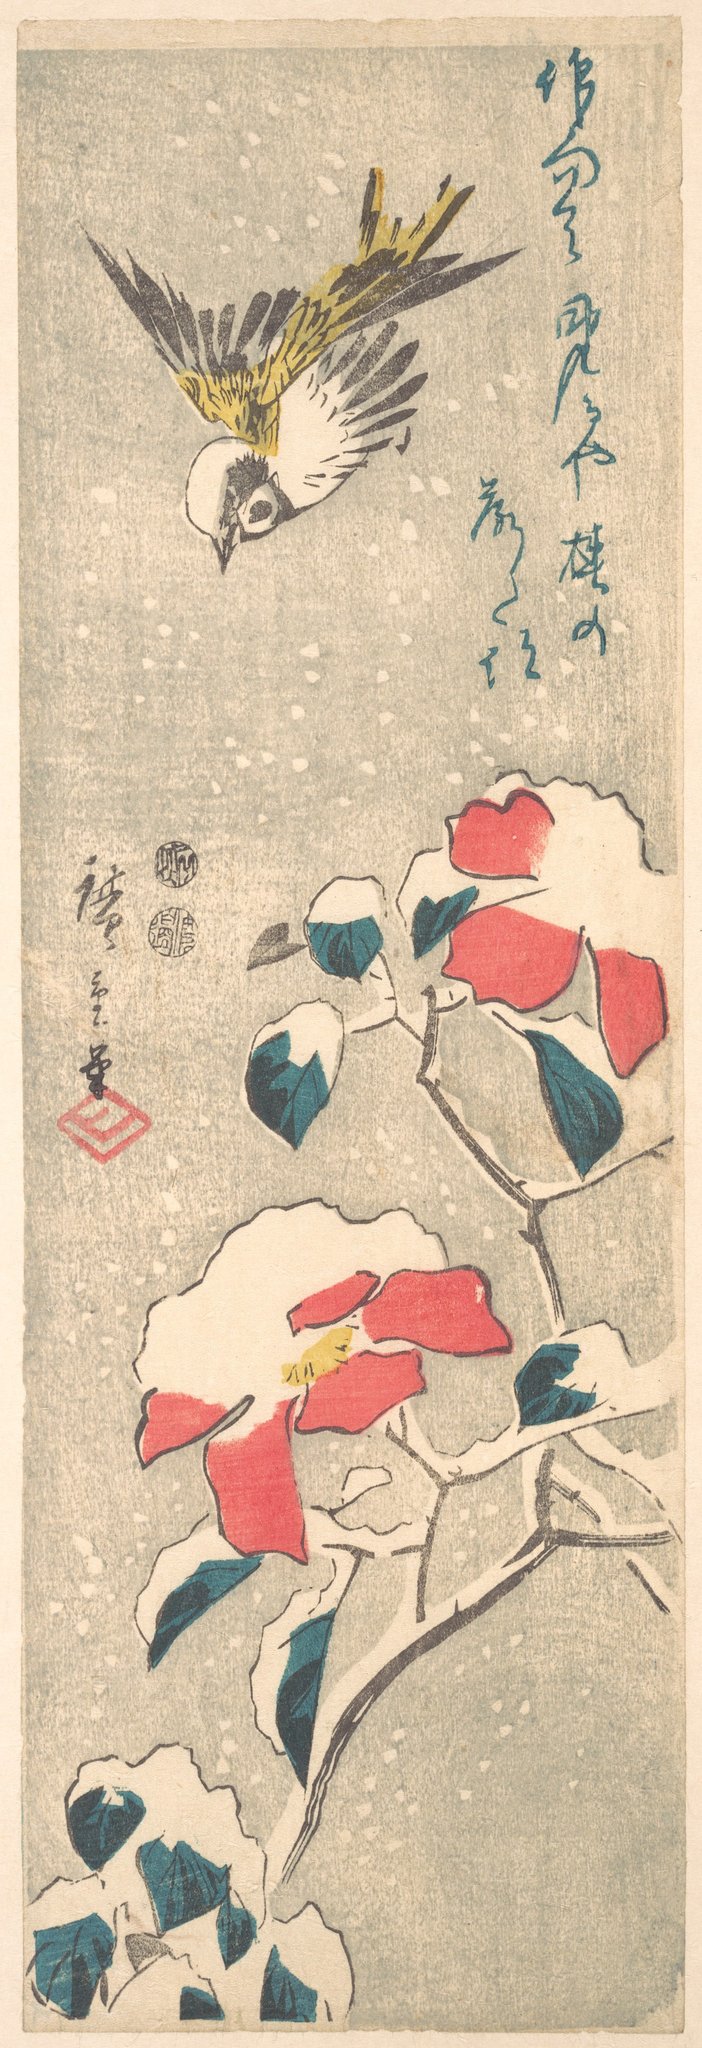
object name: print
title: Sparrow and Snow-covered Camellia (Tsubaki)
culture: japanese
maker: utagawa hiroshige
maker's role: artist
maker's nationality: japanese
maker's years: 1797-1858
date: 1845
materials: ink, paper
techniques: woodblock print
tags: birds,flowers